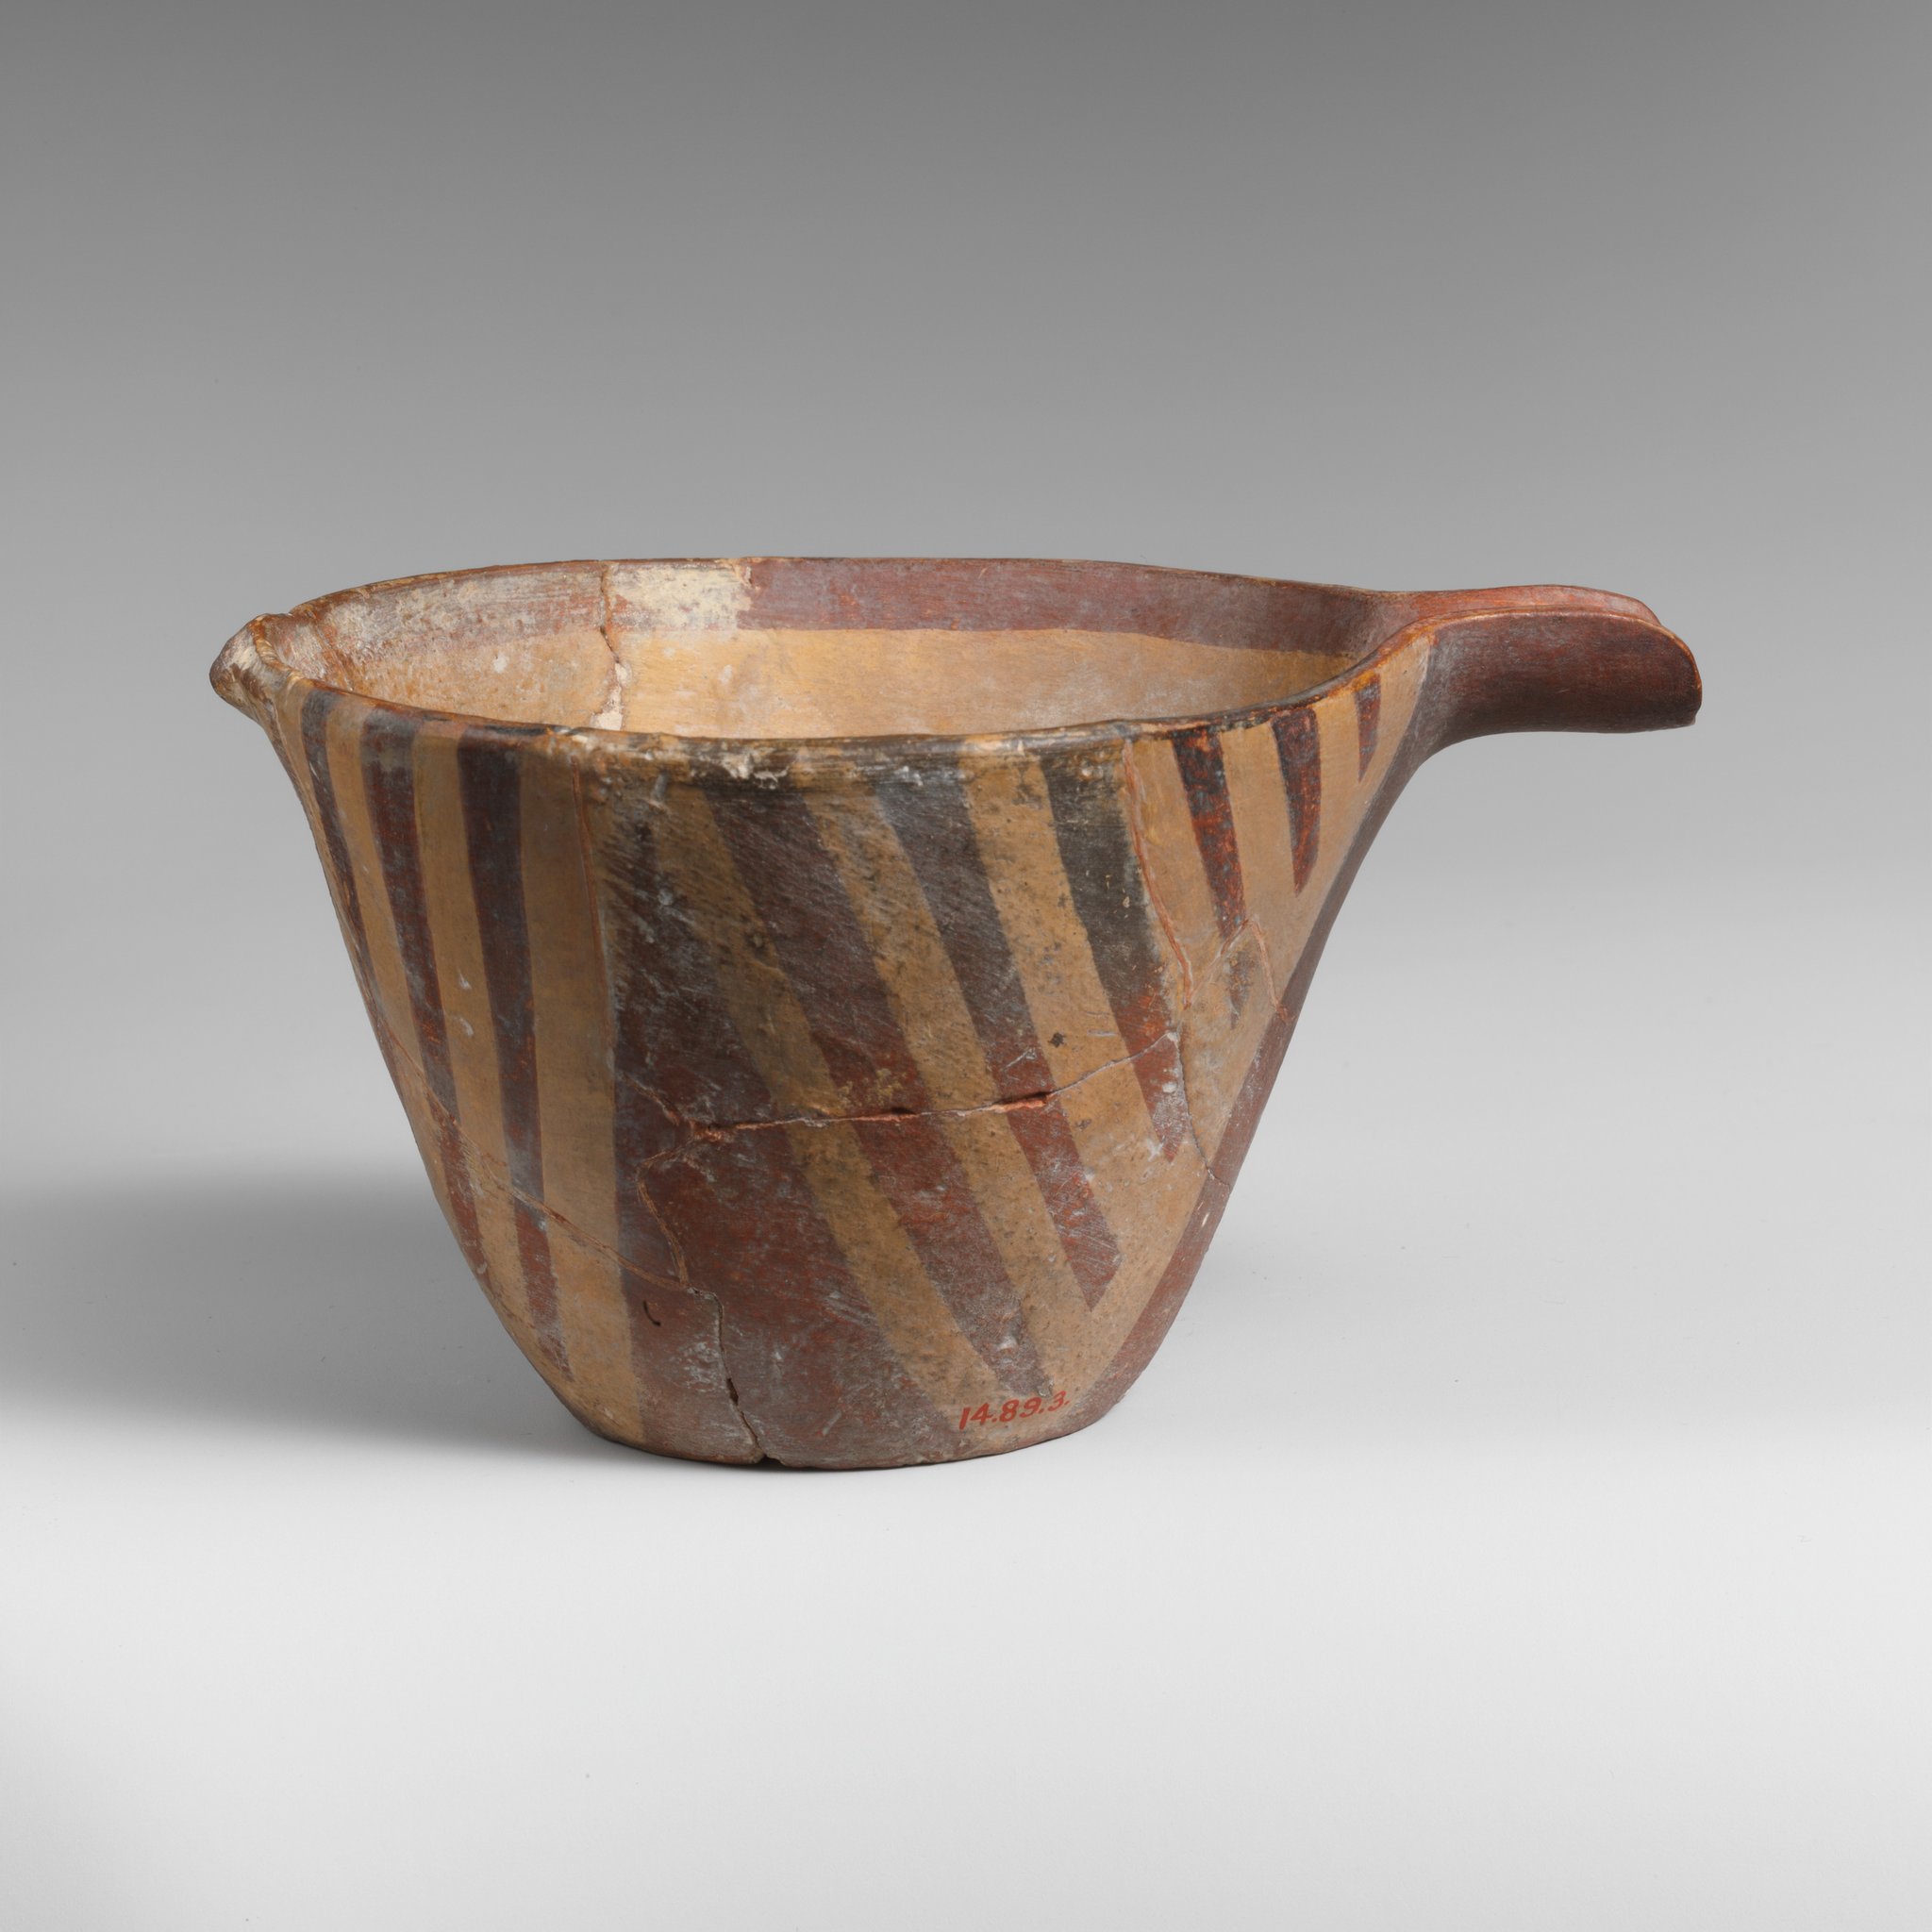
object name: cup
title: Terracotta spouted conical bowl, white-on-dark ware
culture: minoan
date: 2400-2200 BCE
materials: terracotta